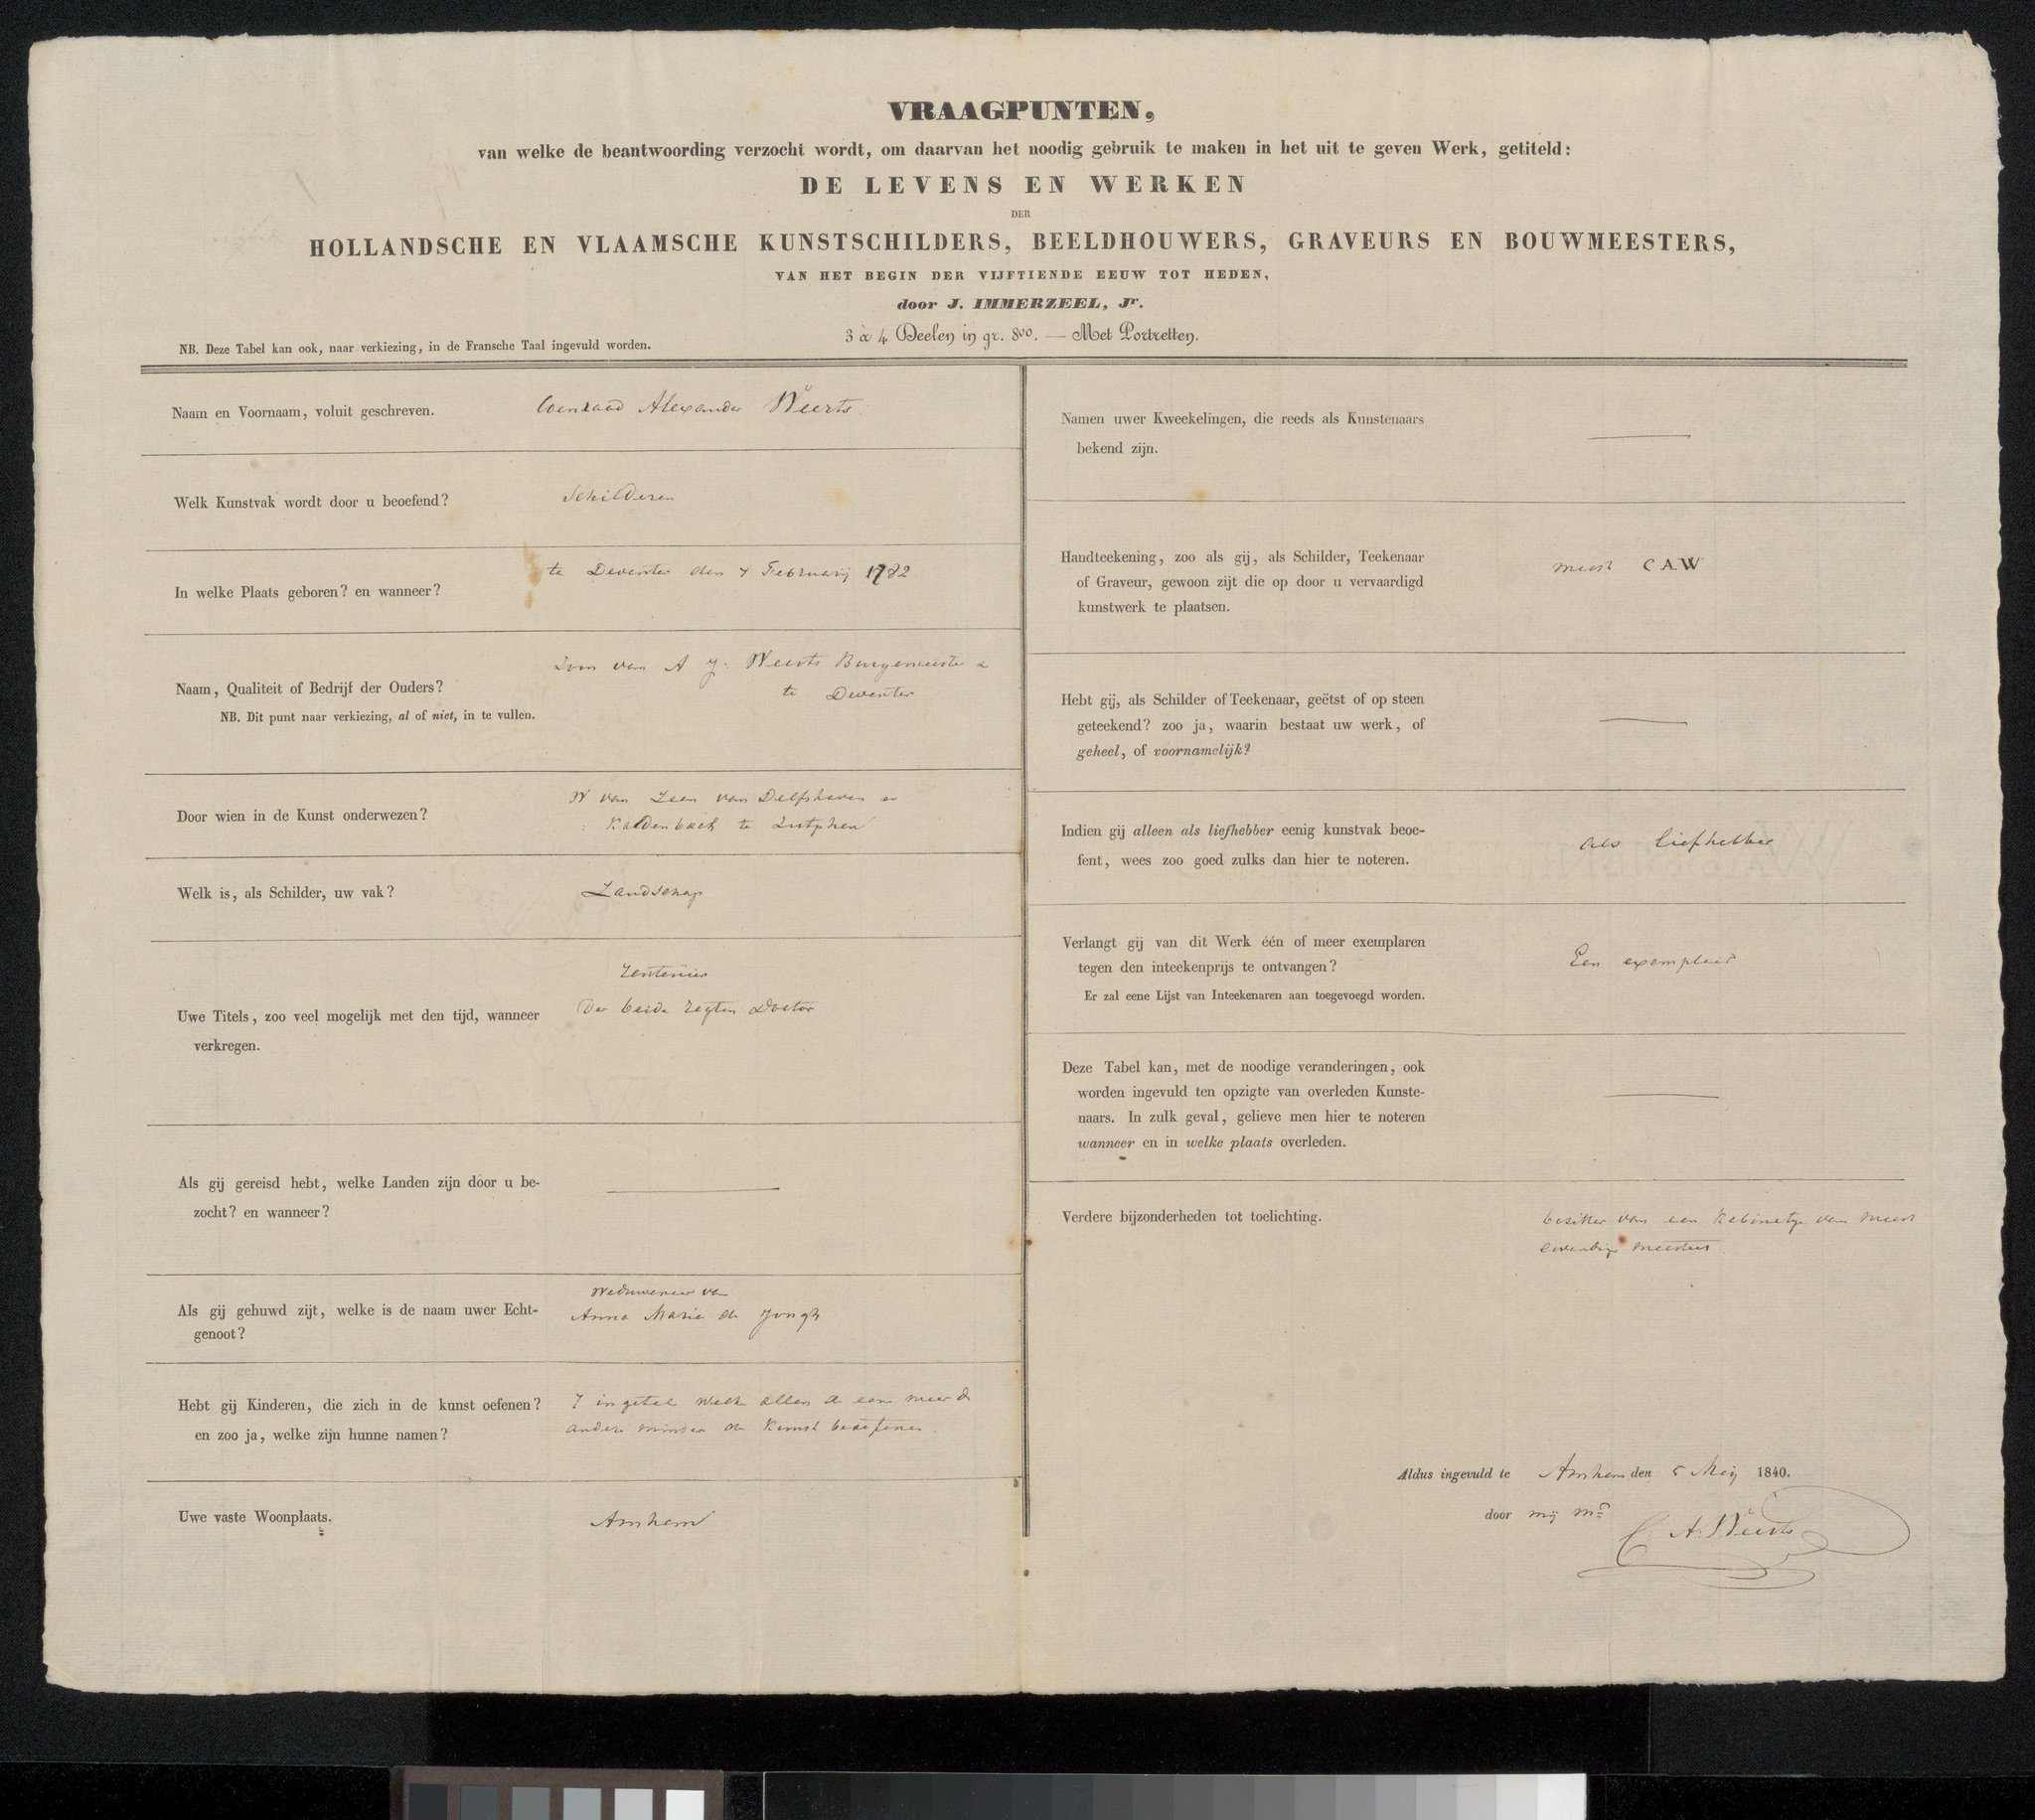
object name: manuscript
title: Enquêteformulier ingevuld door Coenraad Alexander Weerts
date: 1840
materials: ink, paper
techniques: pen, printing, writing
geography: arnhem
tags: deventer, the hague, coenraad alexander weerts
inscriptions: inscription: ‘Vraagpunten,/ van welke de beantwoording verzocht wordt, om daarvan het noodig gebruik te maken in het uit te geven Werk, getiteld: De levens en werken/ der Hollandsche en Vlaamsche kunstschilders, beeldhouwers,/ graveurs en bouwmeesters, van het begin der vijftiende eeuw tot heden/ door J. Immerzeel, Jr.’, watermark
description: Opgenomen in: Immerzeel, J. Jr., De levens en werken der Hollandsche en Vlaamsche kunstschilders, beeldhouwers, graveurs en bouwmeesters, van het begin der vijftiende eeuw tot heden, Amsterdam: J.C. van Kesteren, 1842-1843.